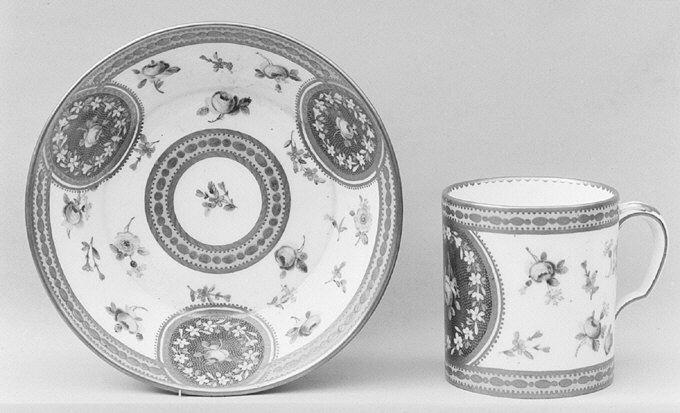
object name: saucer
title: Saucer (soucoupe)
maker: sèvres manufactory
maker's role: manufactory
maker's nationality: french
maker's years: 1740-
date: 1782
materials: soft paste porcelain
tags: flowers